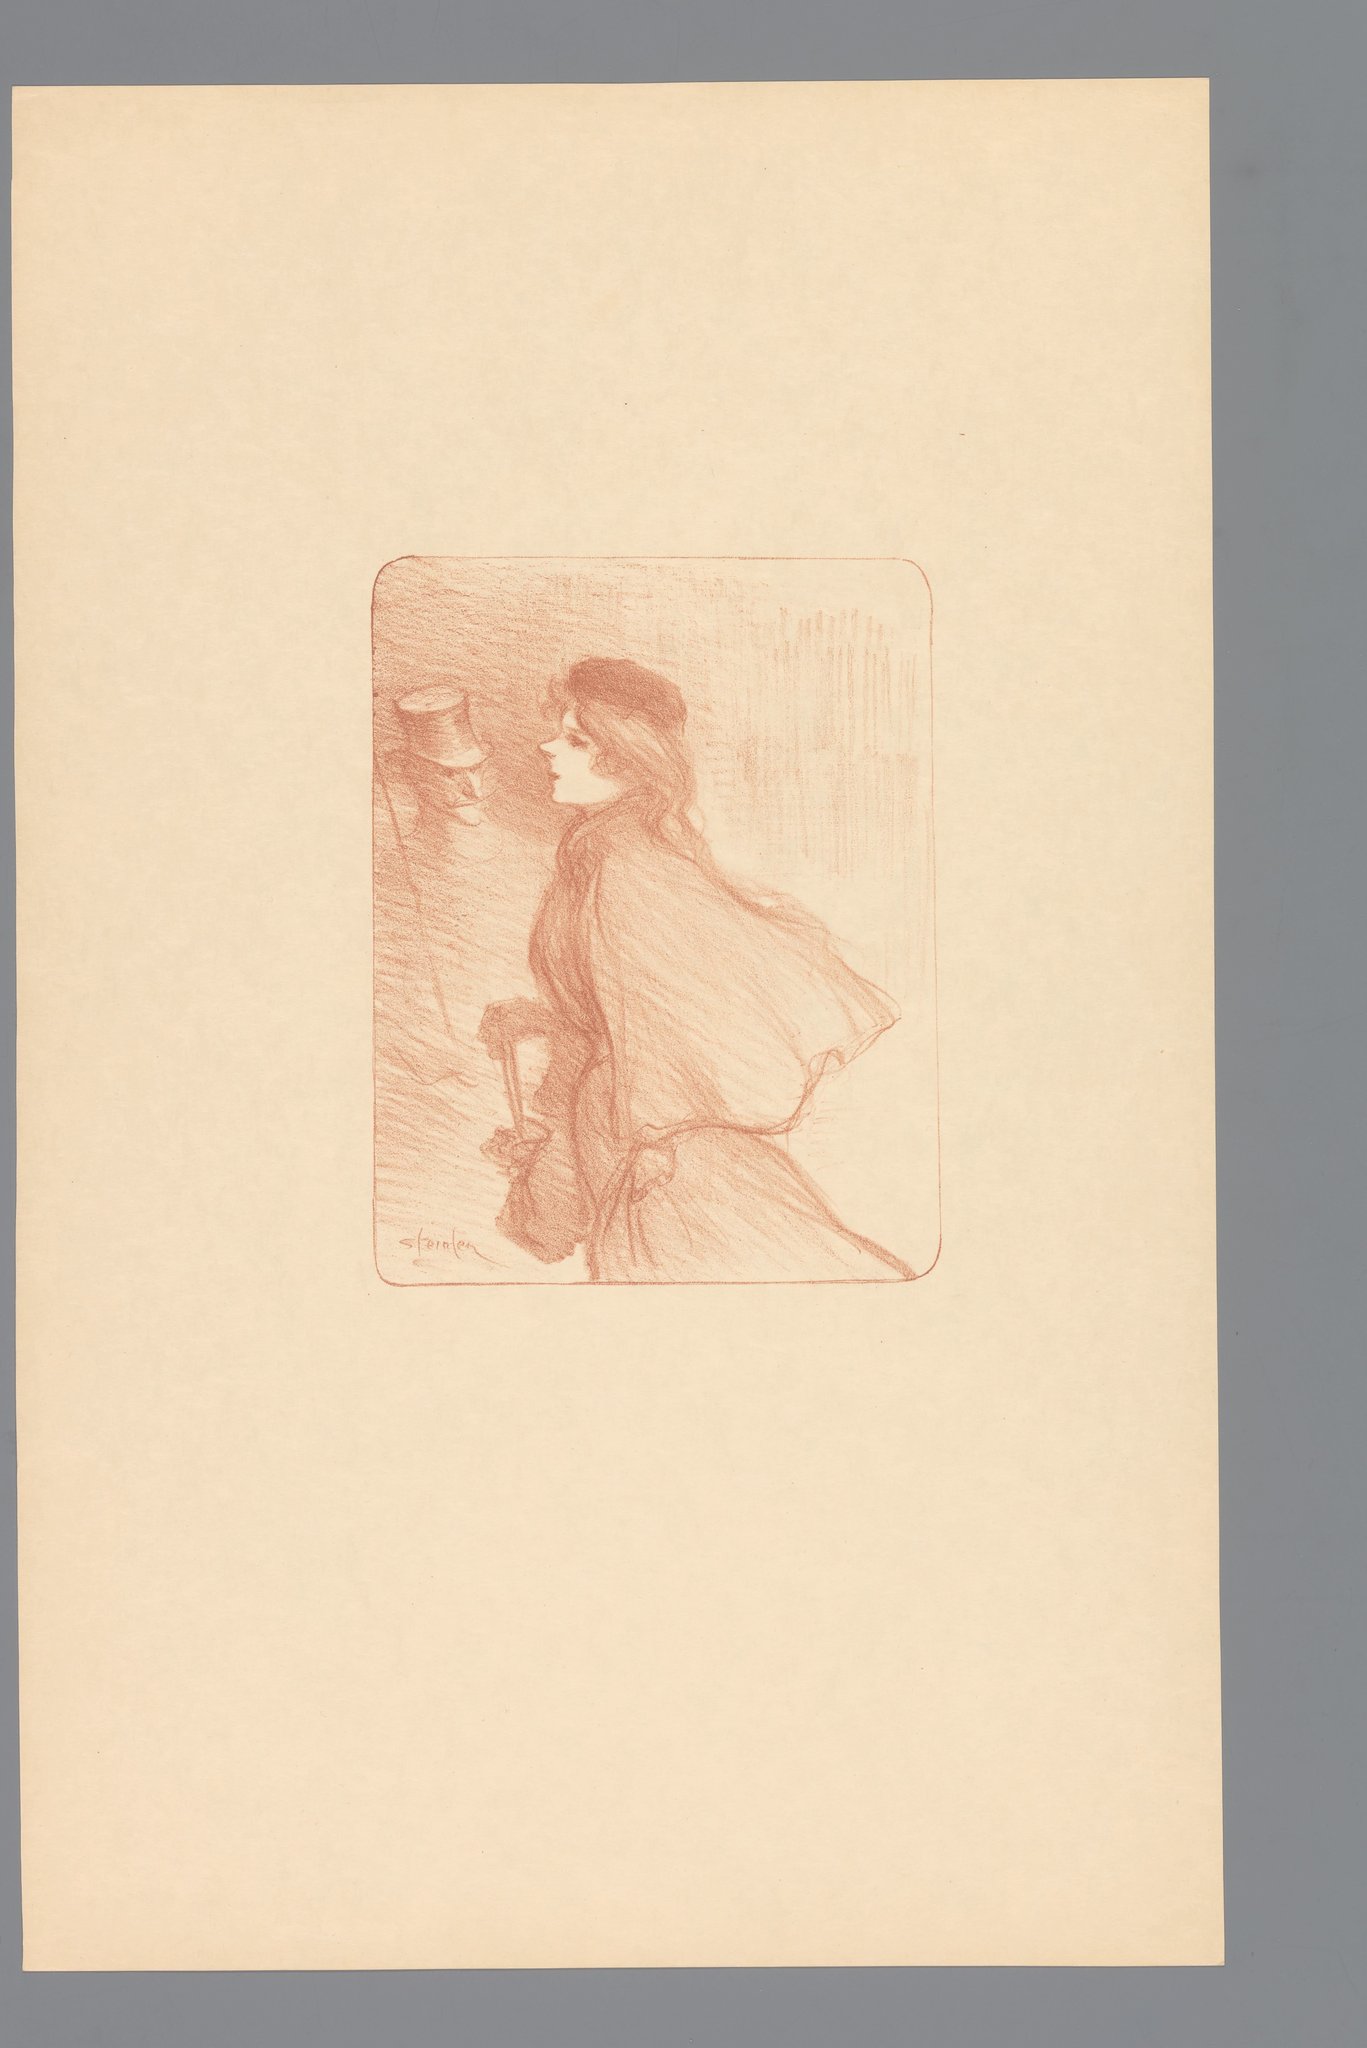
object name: print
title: Chansons de femmes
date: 1896-1897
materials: paper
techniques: lithograph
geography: paris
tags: purse, money-bag, head-gear, female sex; woman, coat, cape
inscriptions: collector's mark: Lugt 2760, collector's mark: Lugt 2228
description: Een dame, van opzij gezien, in matelot met alpino op het hoofd, paraplu aan de arm, naar links lopend. Linksachter het hoofd van een heer met hoge hoed op. Linksonder gesigneerd 'Steinlen'. No. 3 uit een serie van 15 litho's voor de map 'Chansons de Femmes' van Paul Delmet.